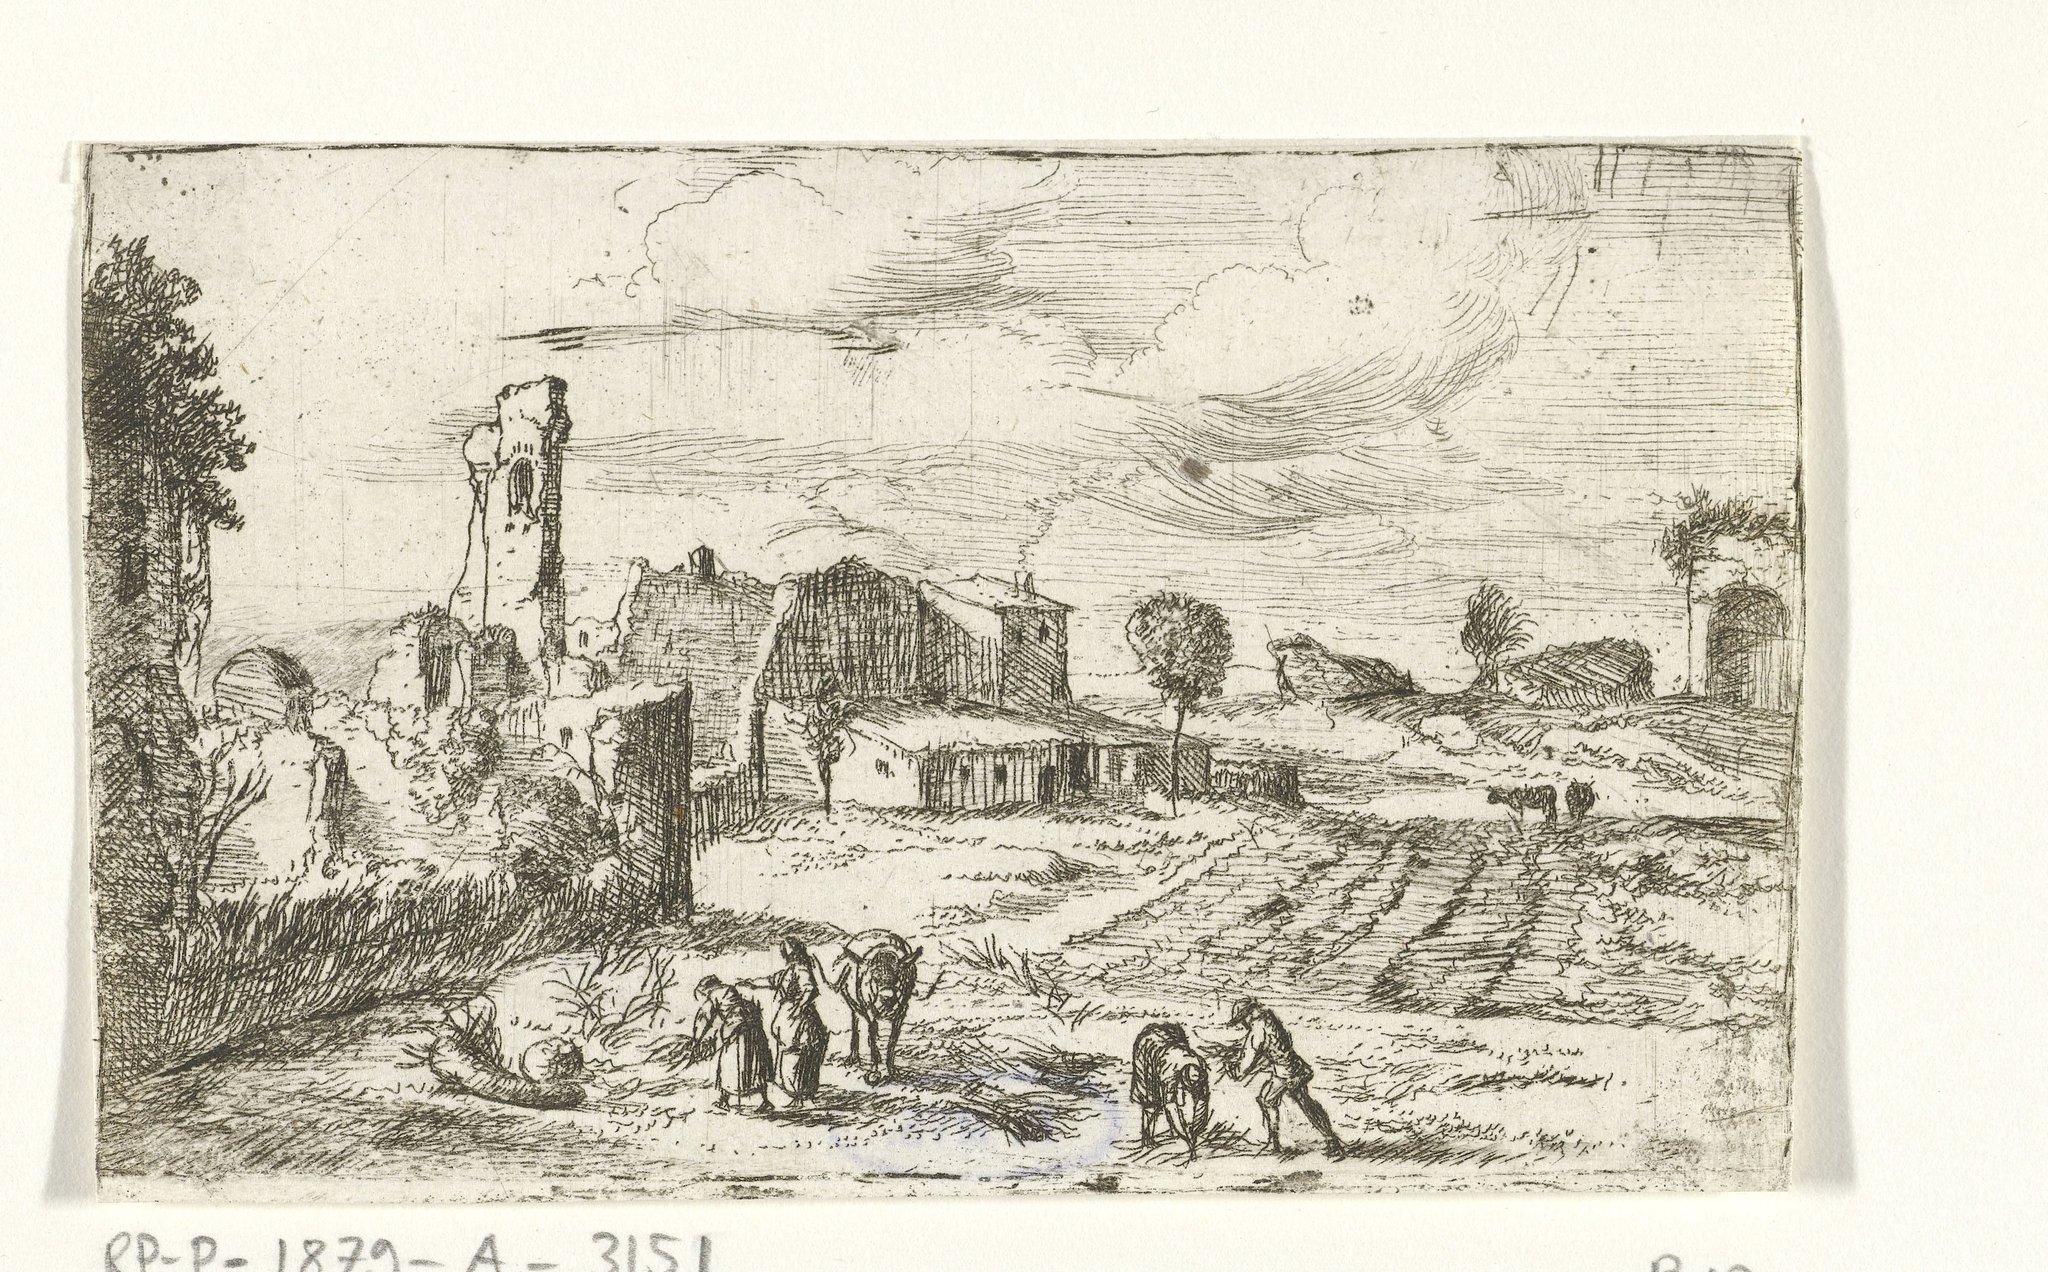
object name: print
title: Landschap met boeren bij het oogsten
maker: jan van ossenbeeck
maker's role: print maker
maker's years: 1623-1674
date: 1647-1674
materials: paper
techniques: etching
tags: harvest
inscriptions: collector's mark: Lugt 2228, collector's mark: Lugt 2610